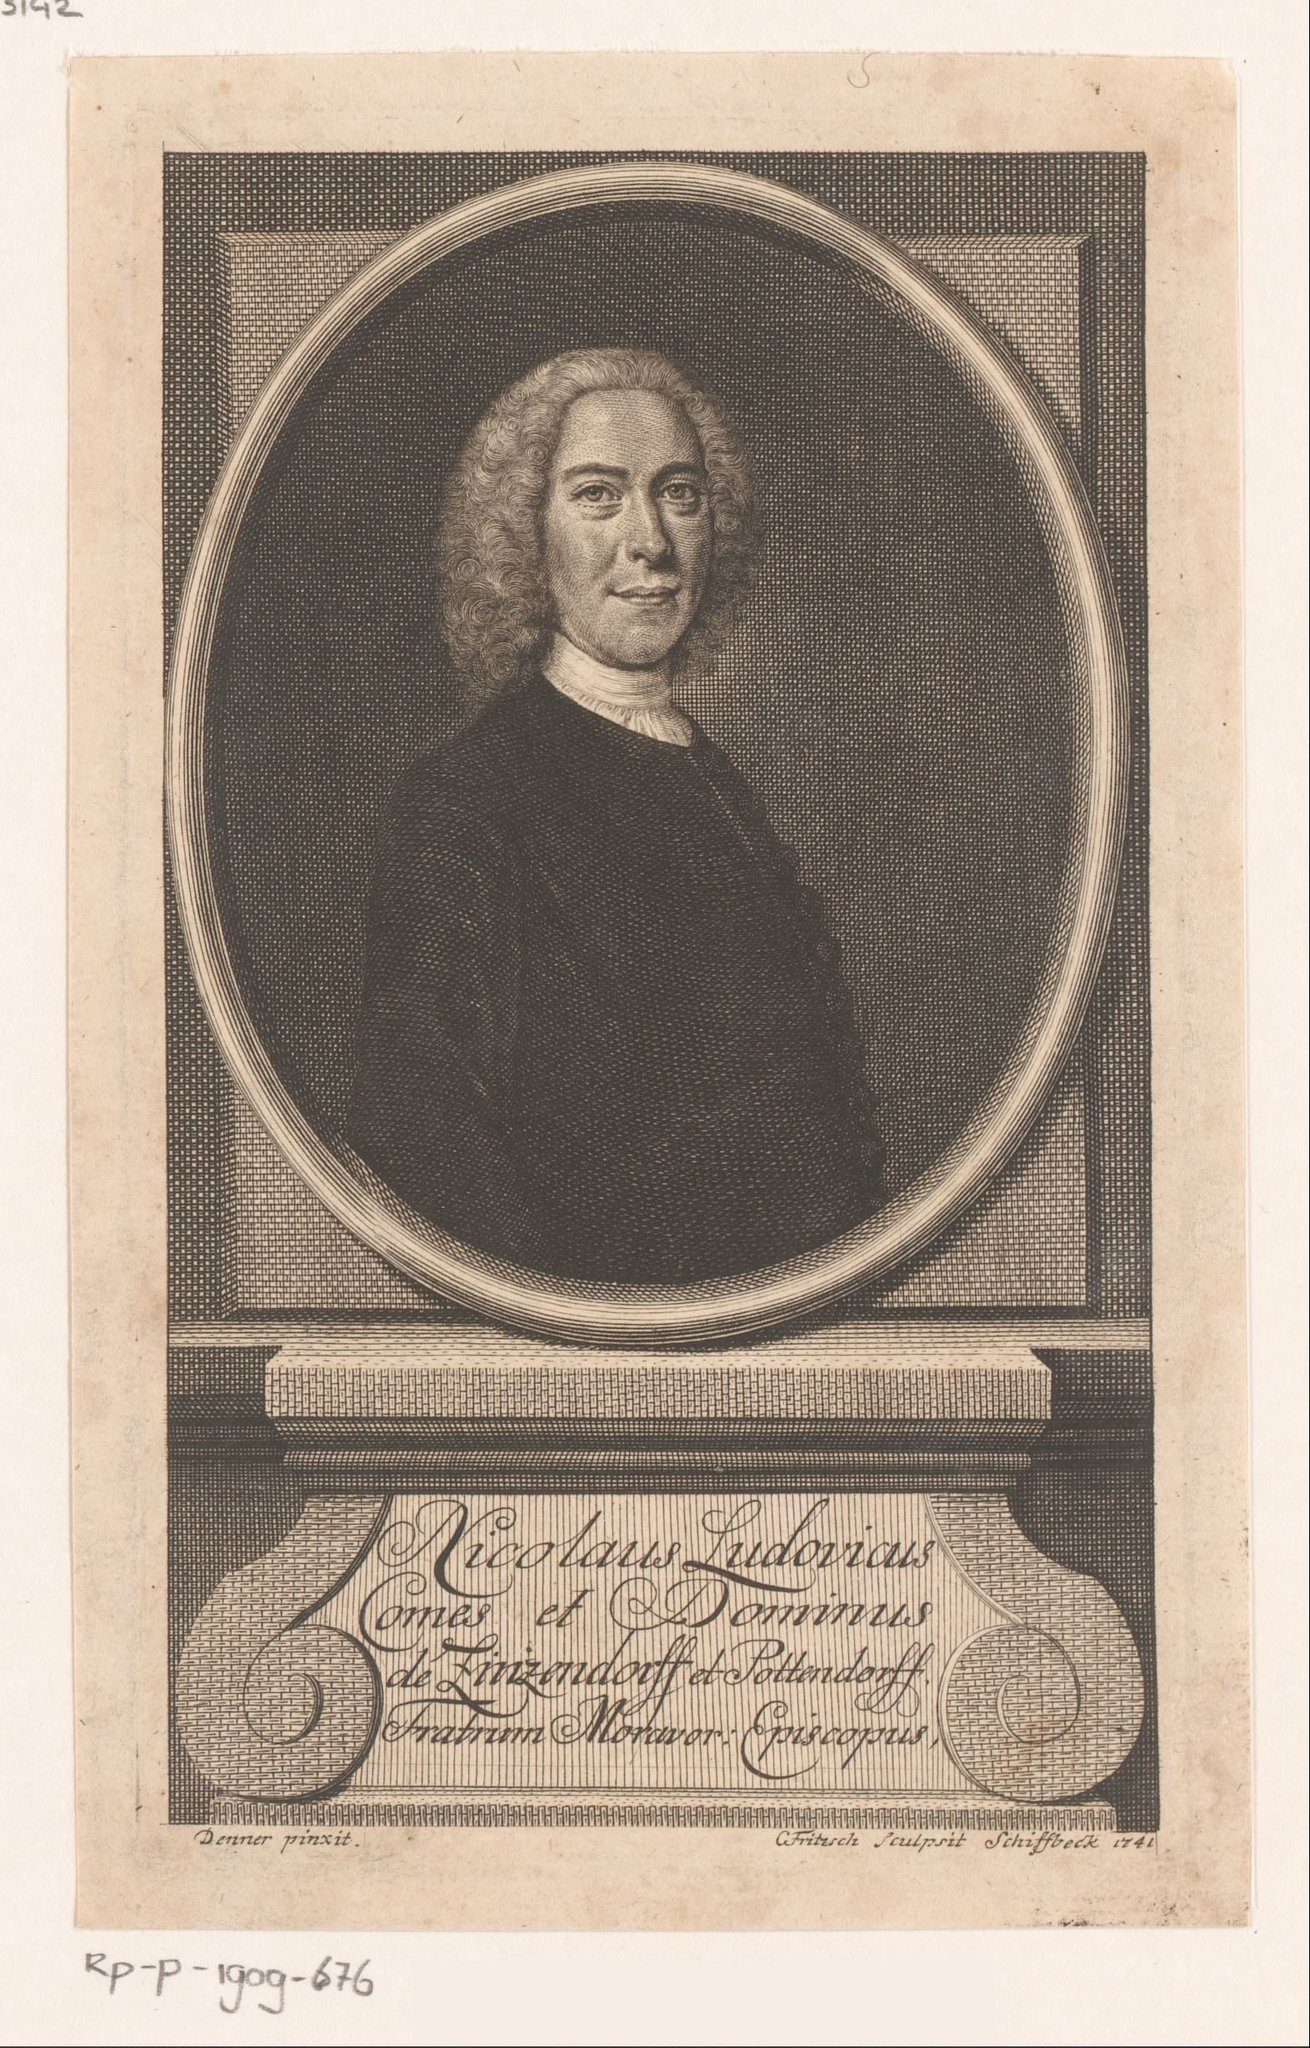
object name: print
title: Portret van Nikolaus Ludwig Graf von Zinzendorf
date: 1741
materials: paper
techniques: engraving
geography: schiffbeck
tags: earl, ornament ~ medallion, historical persons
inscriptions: collector's mark: Lugt 2228